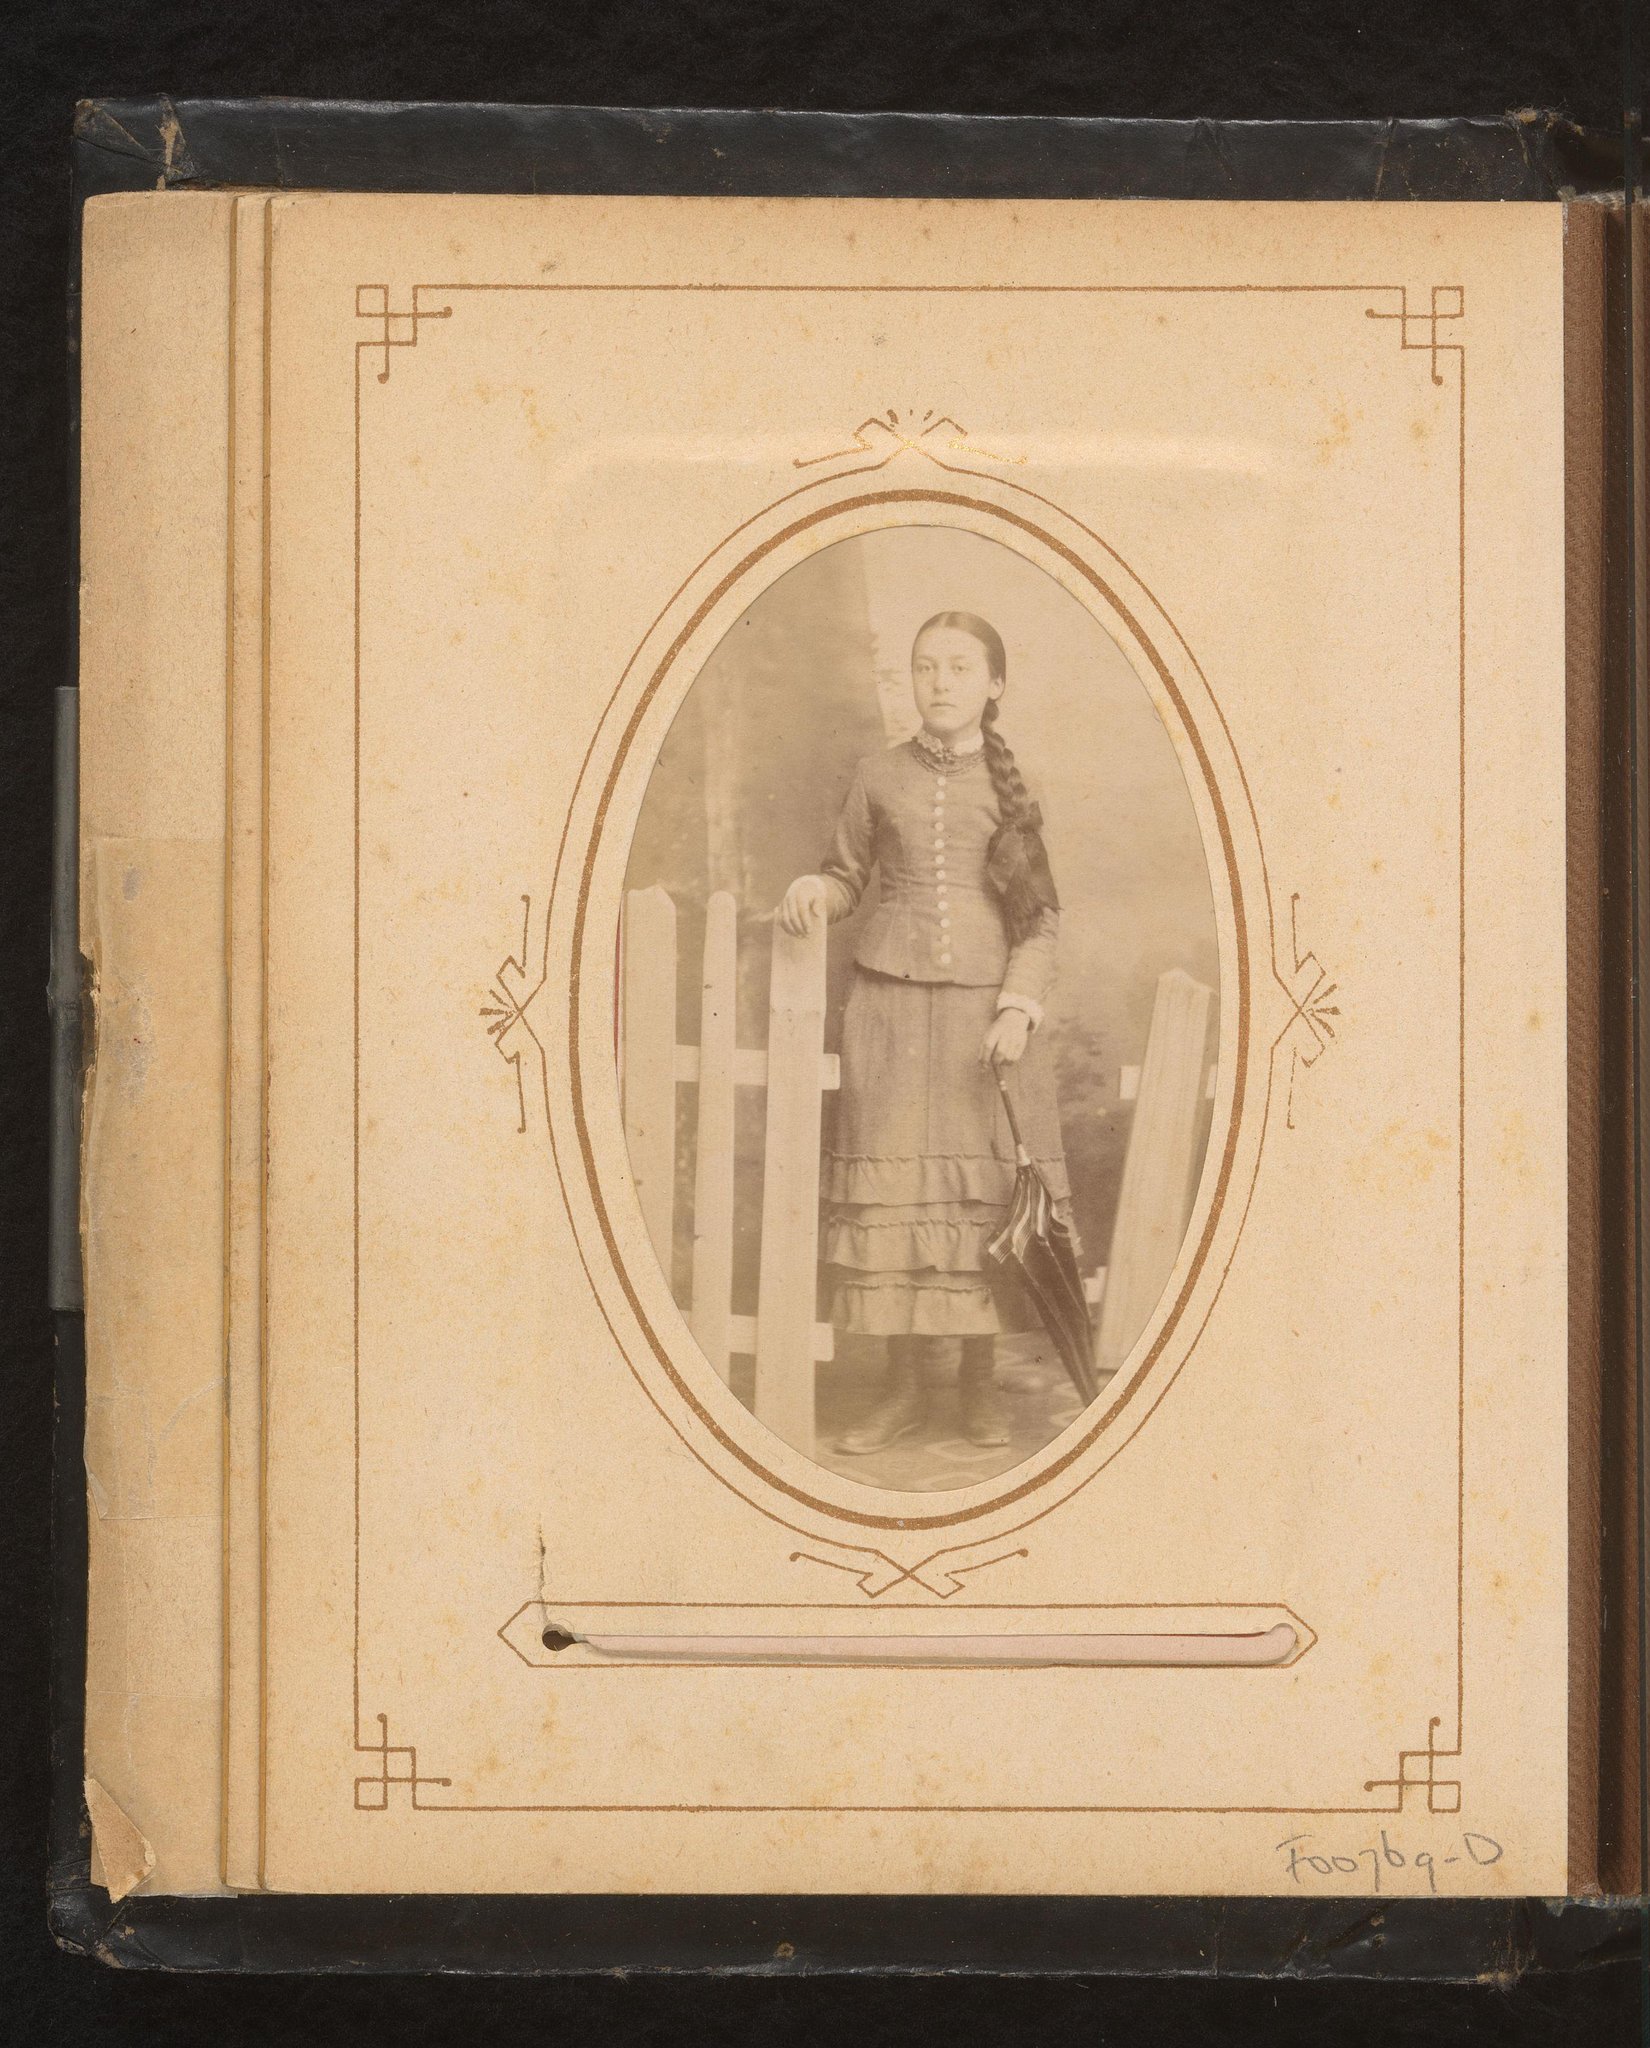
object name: album leaf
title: Portret van een jonge vrouw met paraplu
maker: robert ruegg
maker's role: fotograaf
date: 1870-1900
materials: cardboard, photographic support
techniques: albumen print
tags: adolescent, young woman, maiden, historical persons, umbrella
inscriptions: inscription: ‘Photographie/ Robert Ruegg/ Badstrasse No. 516/ Baden/ Schweiz (...)’